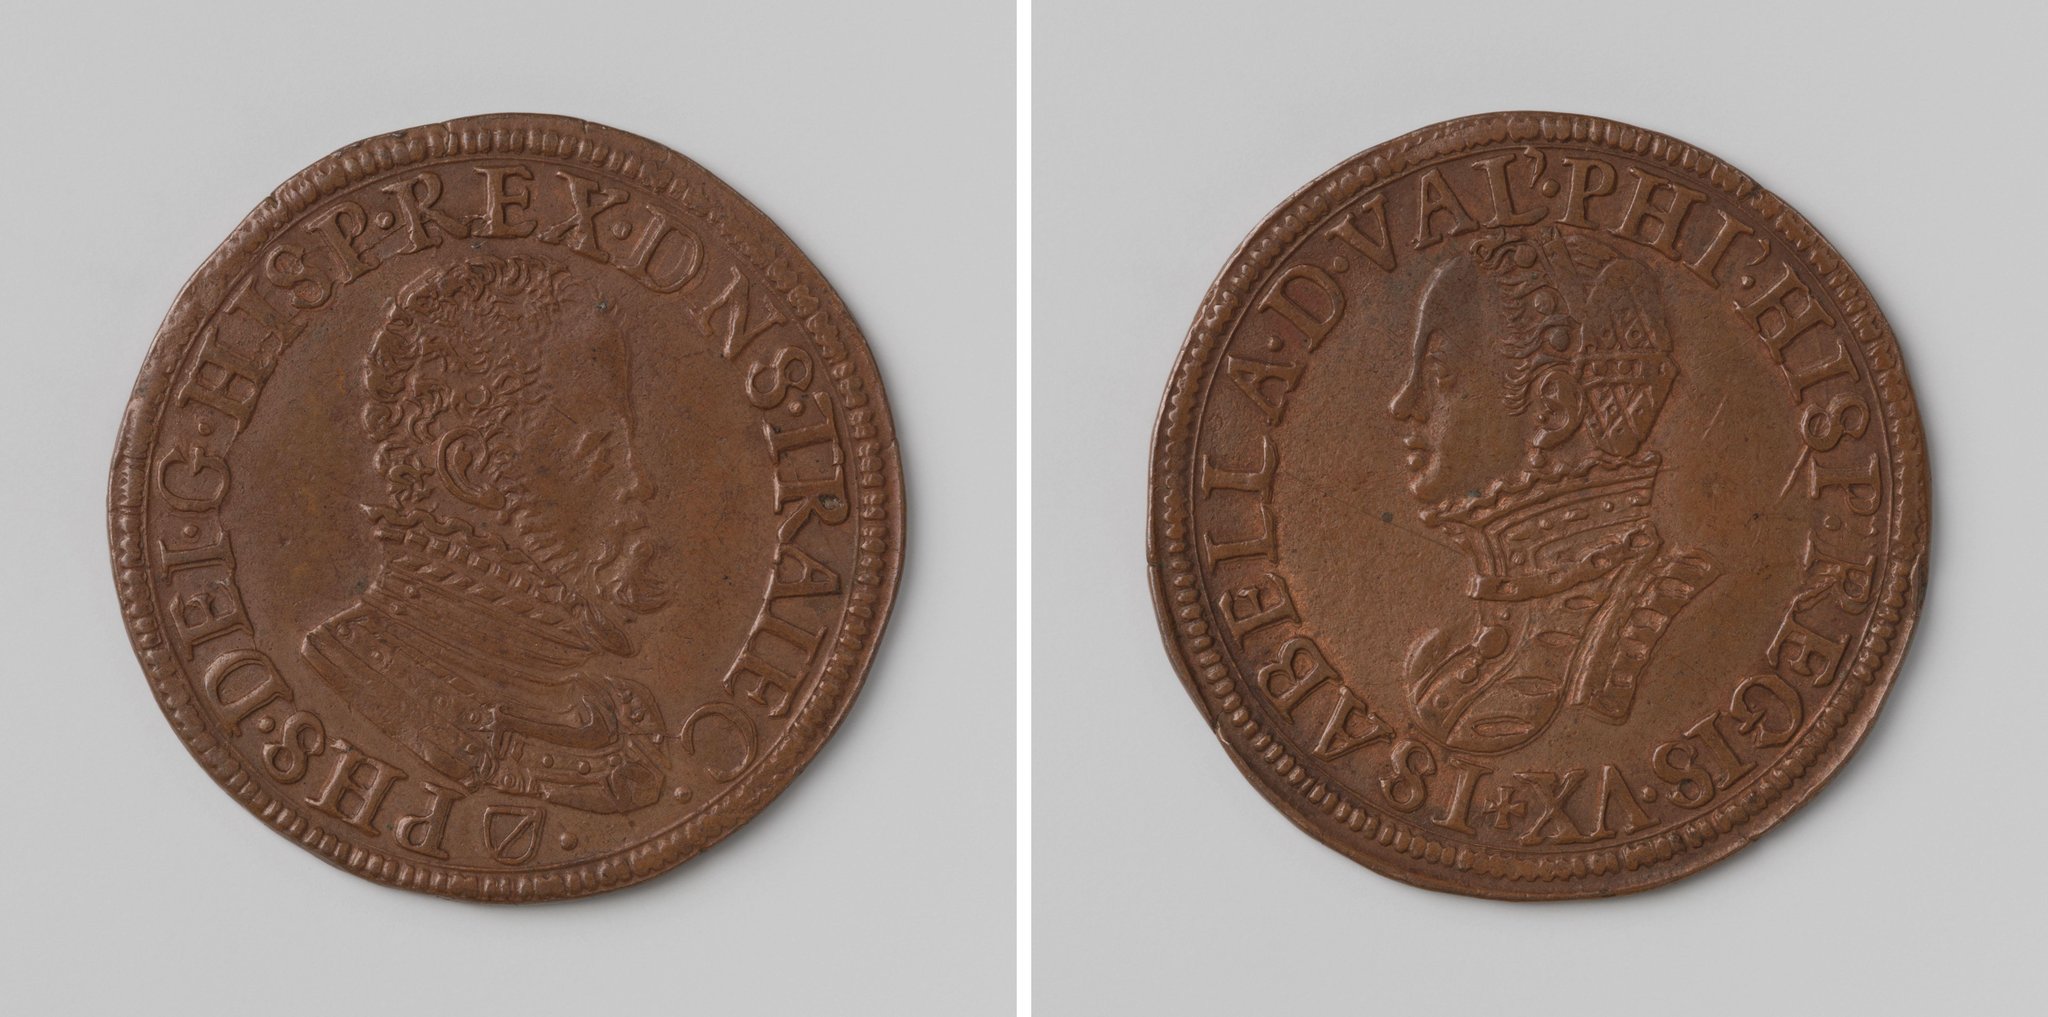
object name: jeton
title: Huwelijk van Filips II, koning van Spanje en Elisabeth van Valois, overeenkomstig de voorwaarden van de vrede van Le Cateau-Cambresis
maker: Anonymous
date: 1559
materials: copper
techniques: striking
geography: utrecht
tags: philip ii of spain, utrecht, paris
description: Koperen penning. Voorzijde: borststuk man binnen omschrift. Keerzijde: borststuk vrouw binnen omschrift